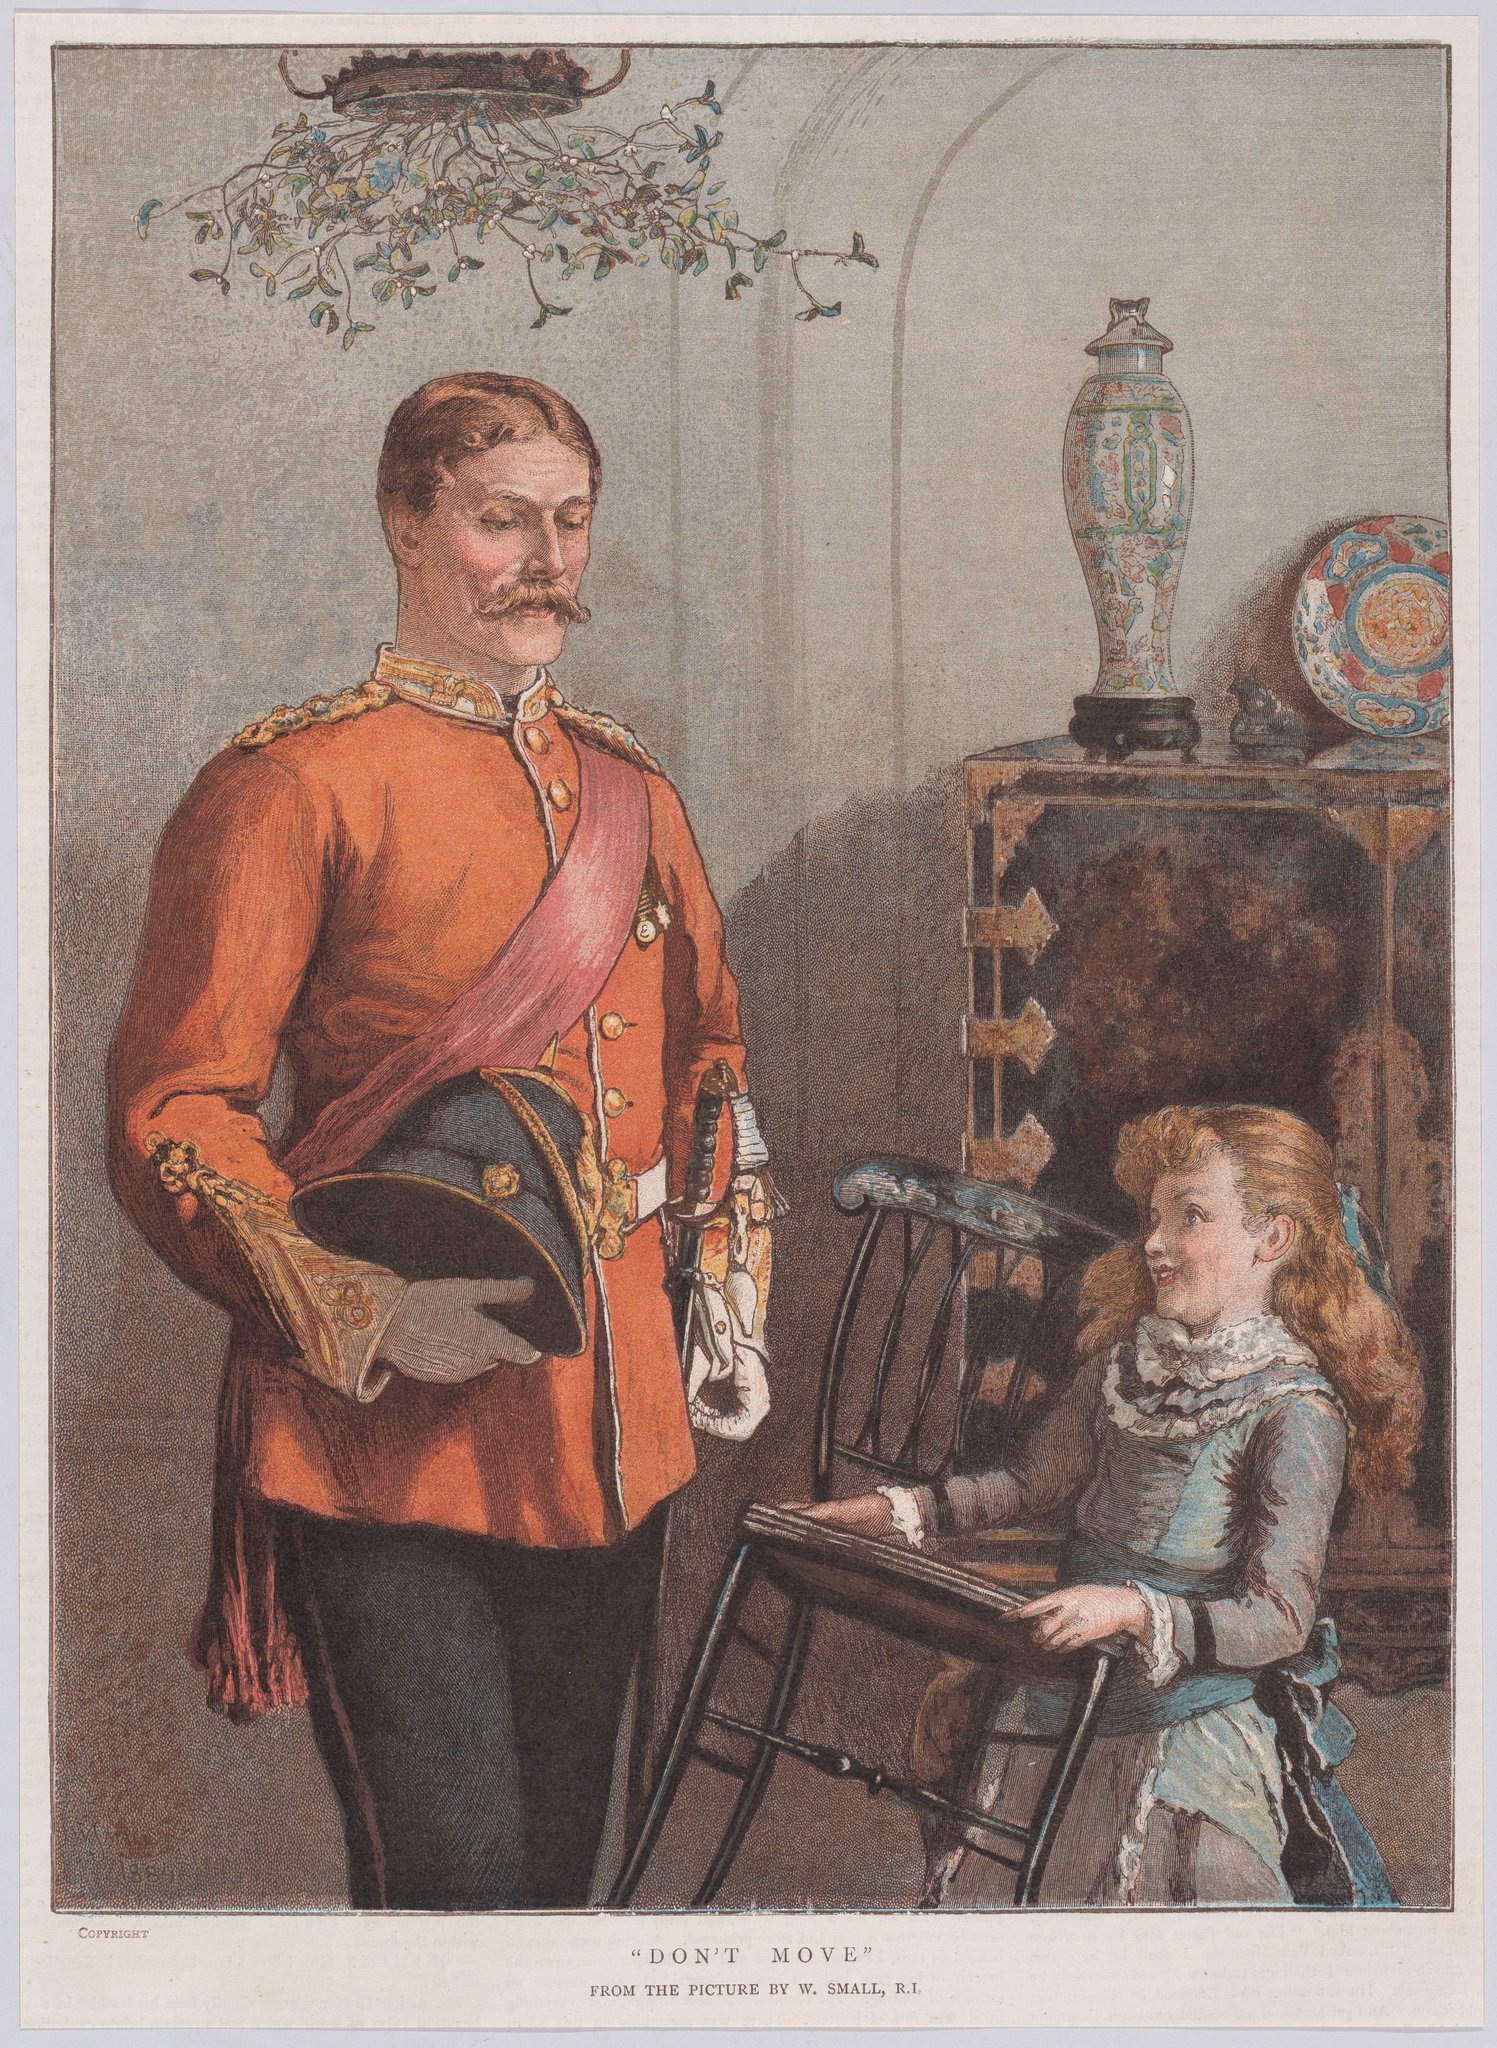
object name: print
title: Don't Move, from "The Graphic" Christmas Number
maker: william small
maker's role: artist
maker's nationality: british, scottish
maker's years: 1843-1929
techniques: engraving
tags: soldiers,girls,men